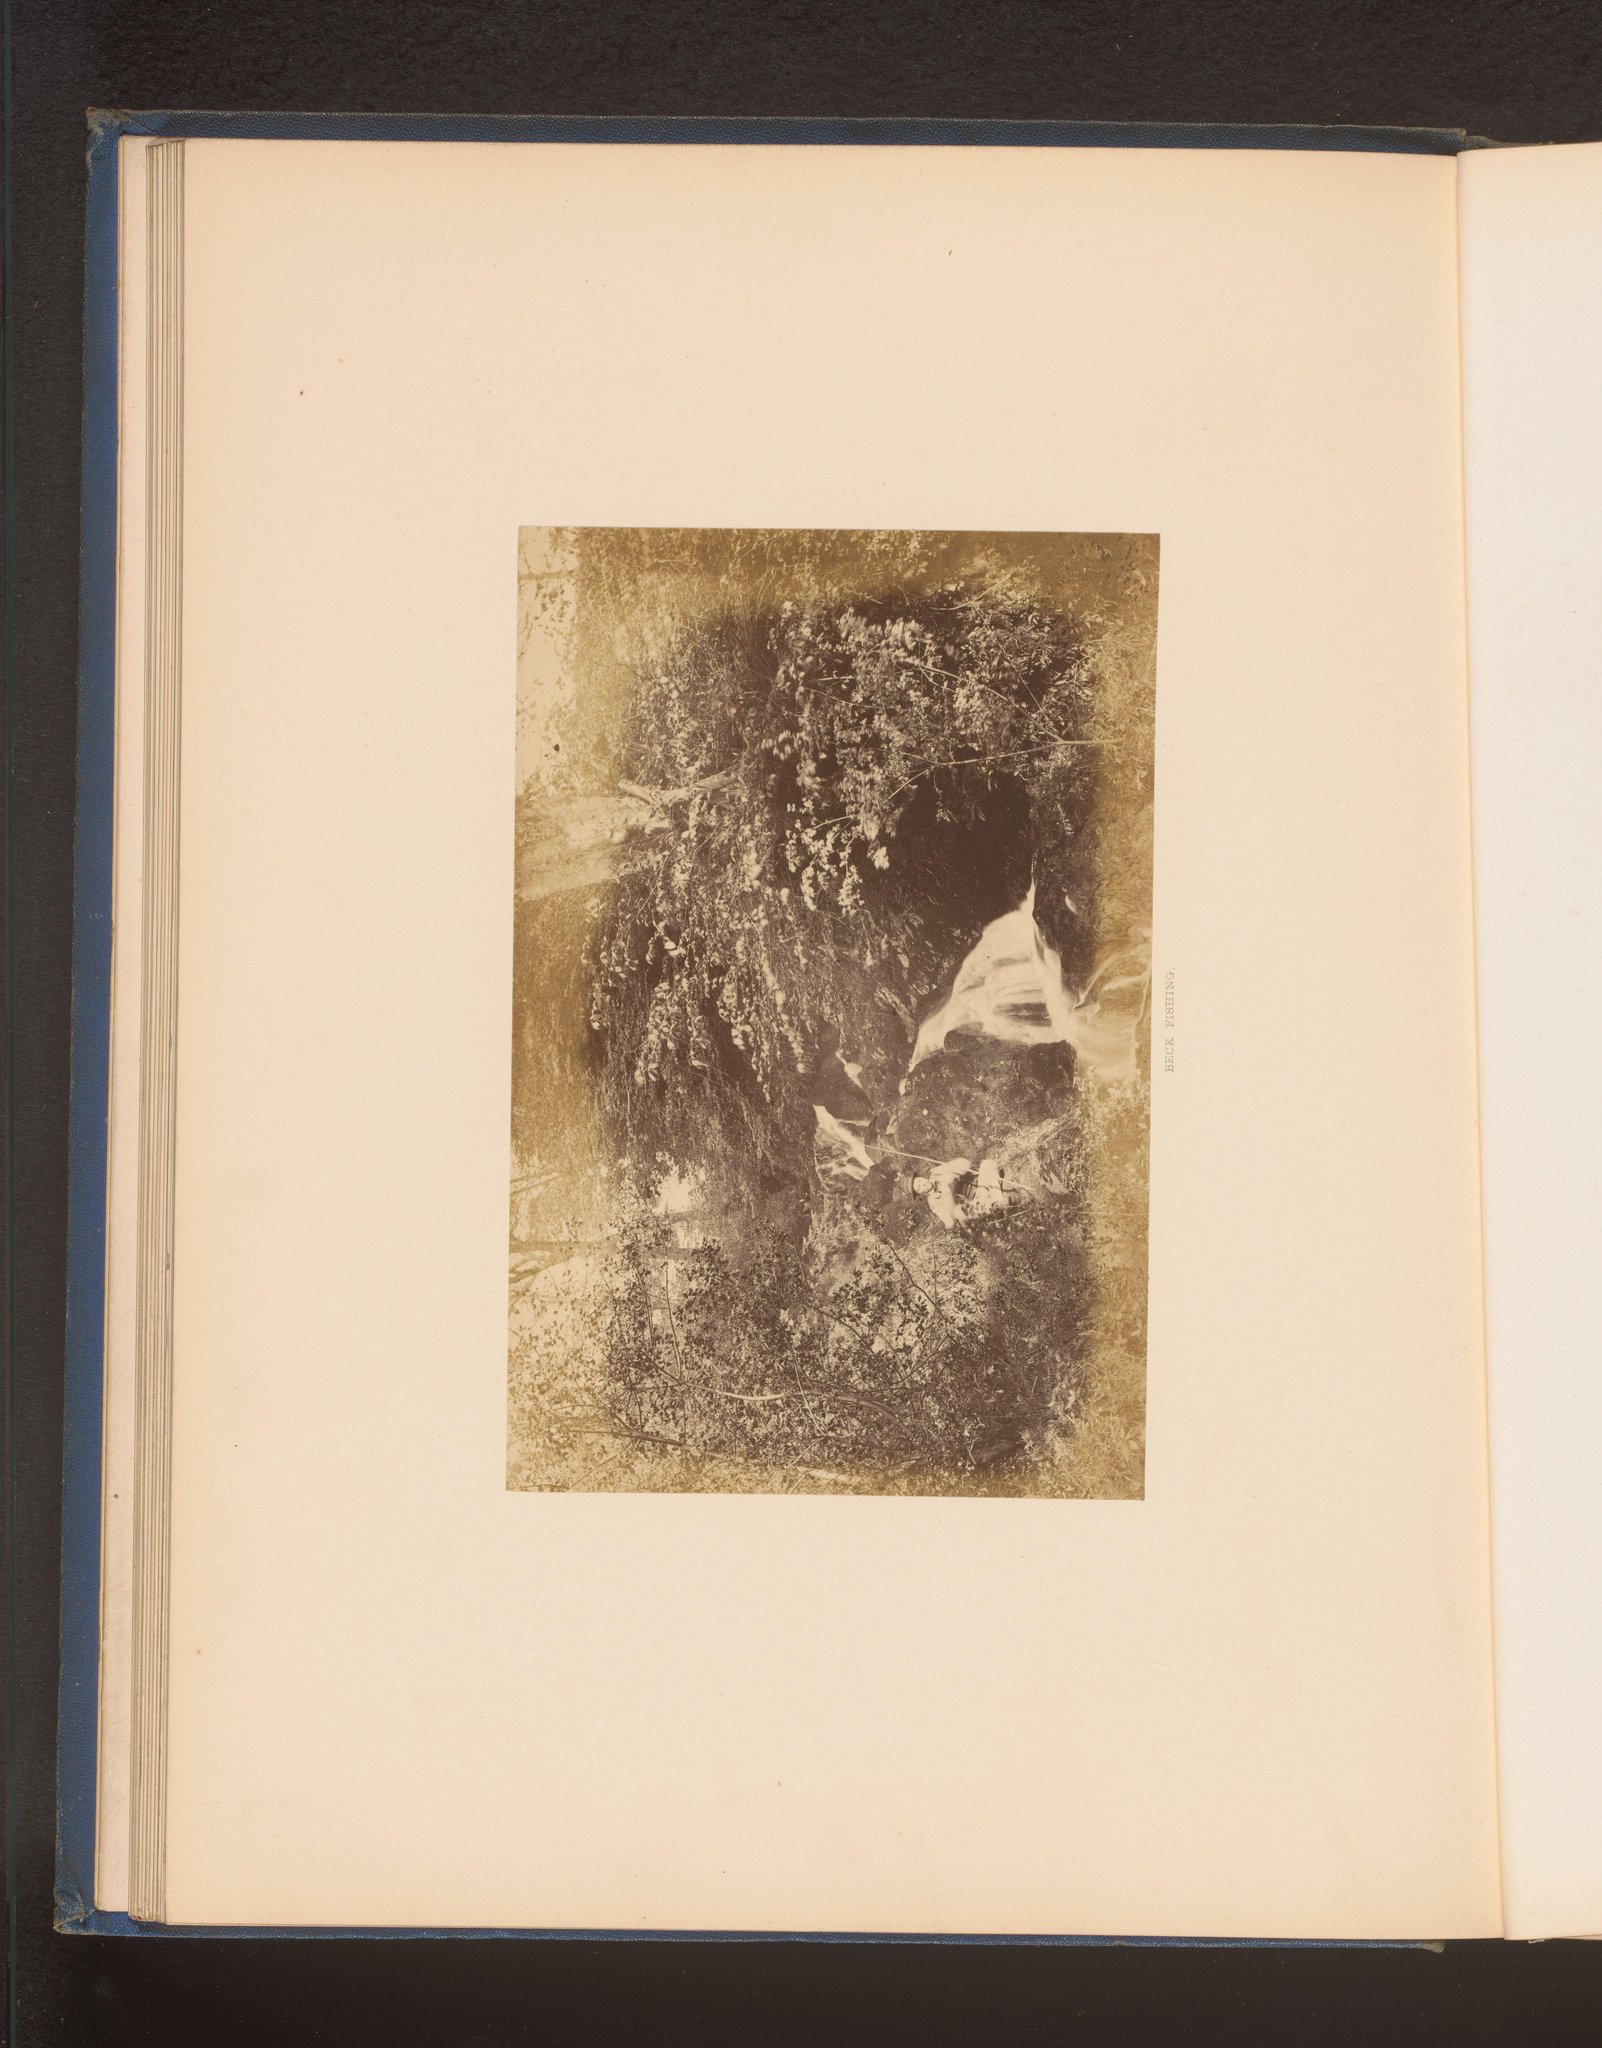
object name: photograph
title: Man vissend bij een waterval in Lake District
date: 1857-1867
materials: photographic support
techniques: albumen print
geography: lake district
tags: waterfall